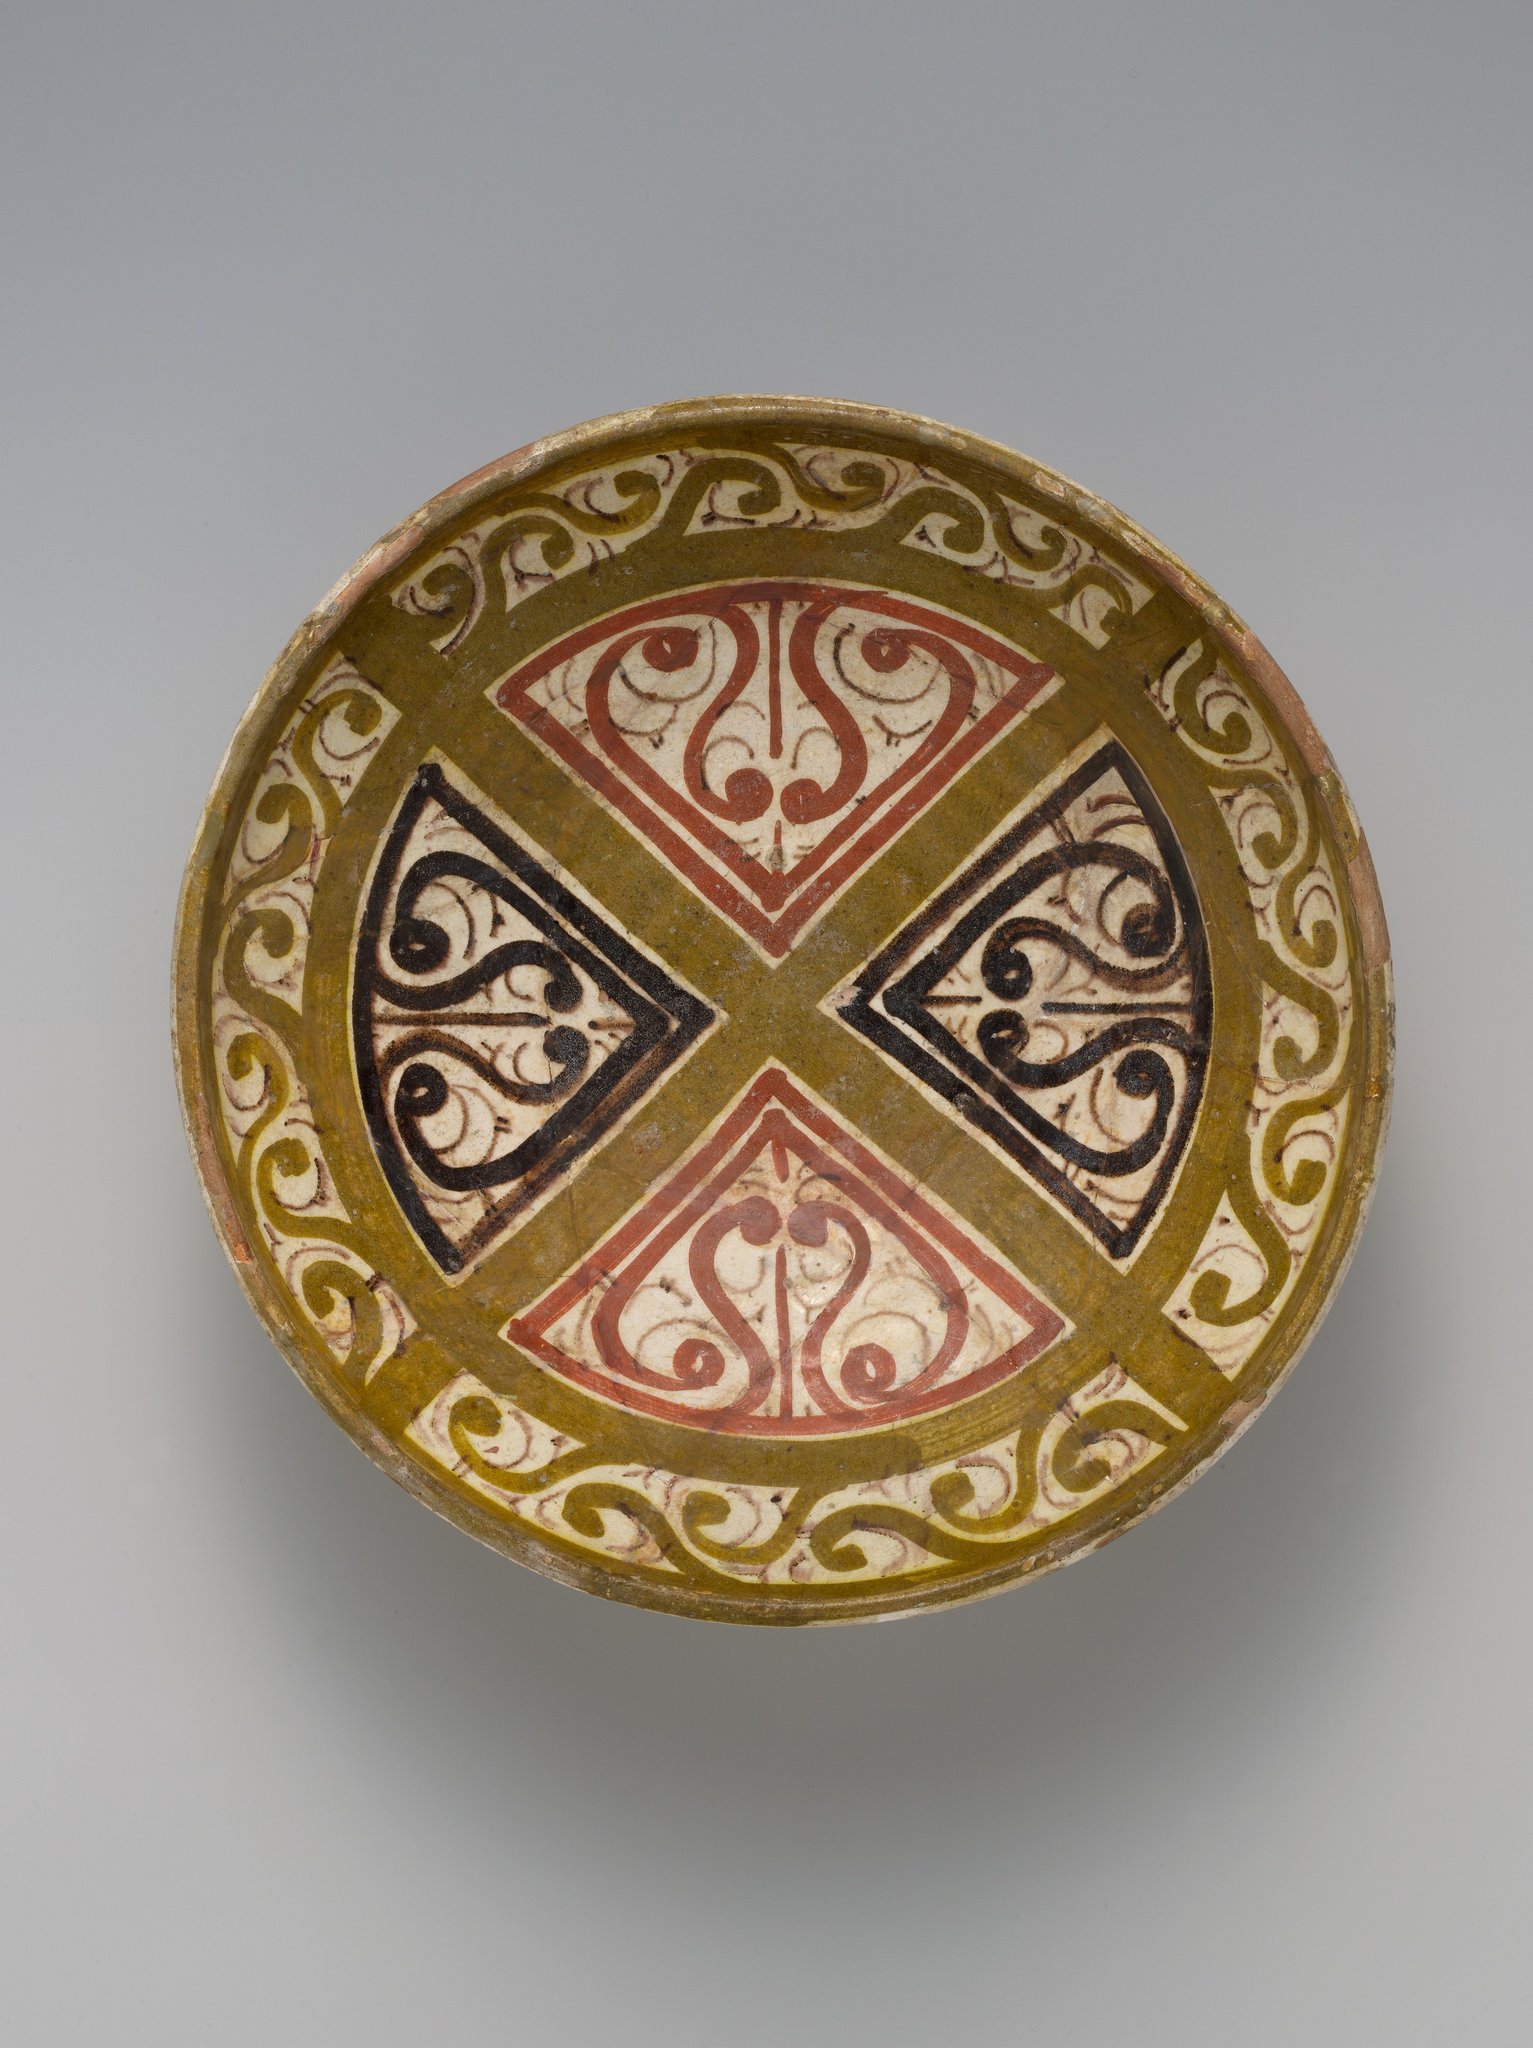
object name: dish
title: Bowl Decorated in the 'Beveled Style'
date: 901-1000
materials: earthenware, glaze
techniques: polychrome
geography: uzbekistan